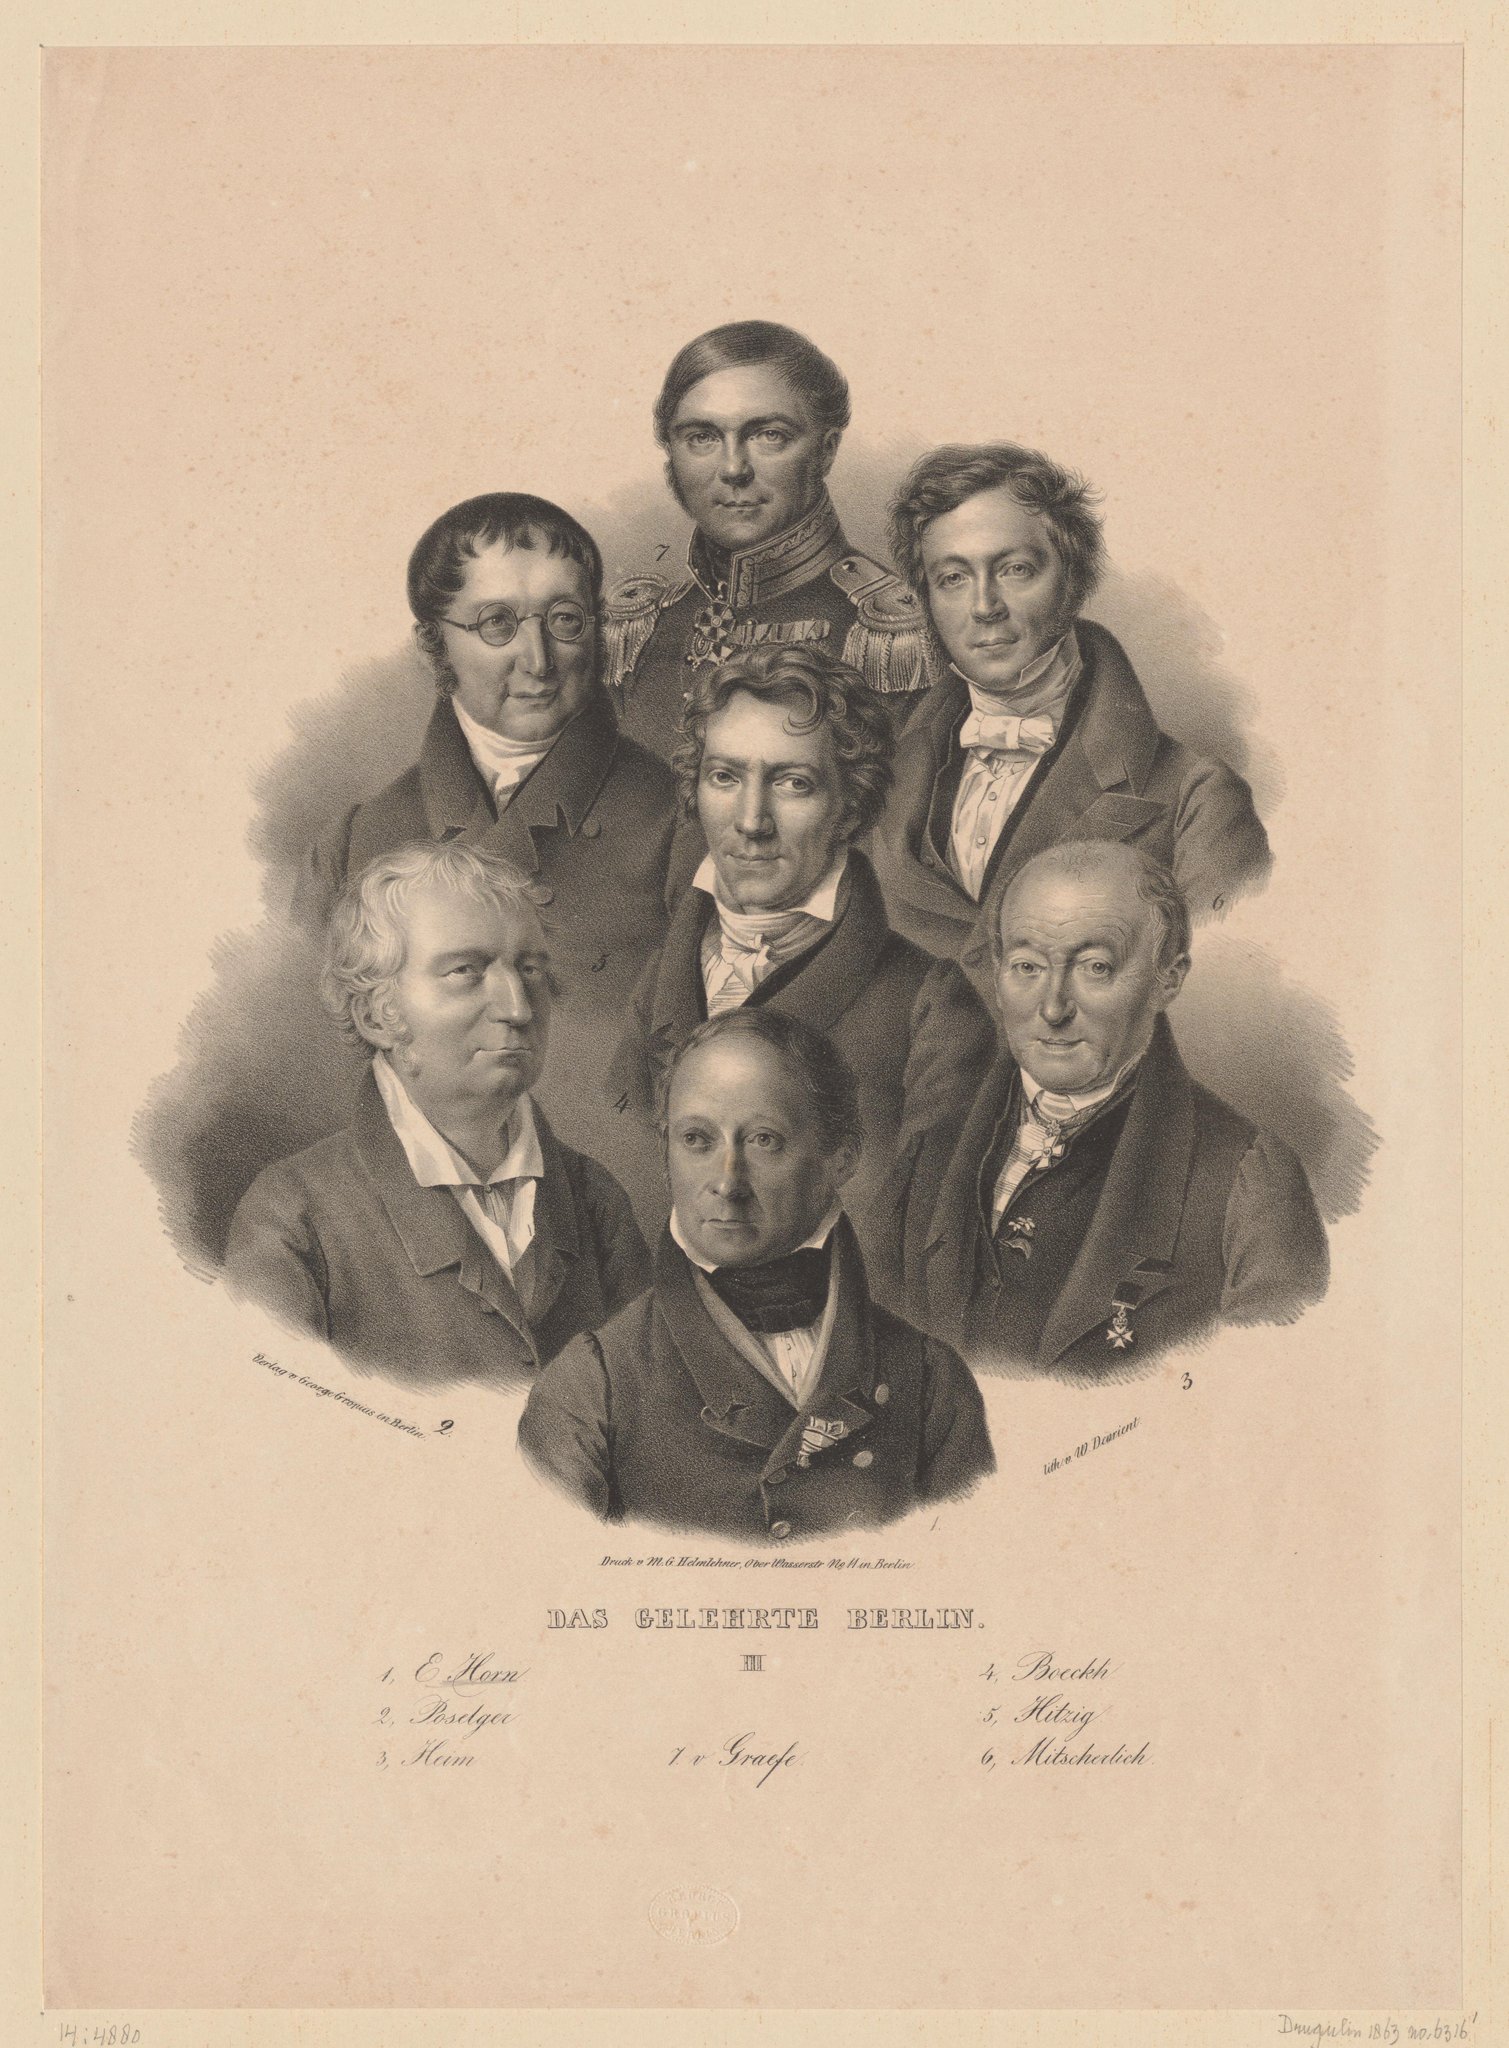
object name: print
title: Das Gelehrte Berlin III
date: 1812-1842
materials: paper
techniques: lithograph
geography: berlin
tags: karl ferdinand von gräfe, berlin, ernst horn, publisher, scholar, philosopher, historical persons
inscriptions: collector's mark: Lugt 2228, workshop stamp: Lugt 4607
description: Portretten van Ernst Horn, Friedrich Theodor Poselger, Ernst Ludwig Heim, Friedrich von Boeckh, Julius Eduard Hitzig, Eilhard Mitscherlich en Karl Ferdinand von Gräfe.